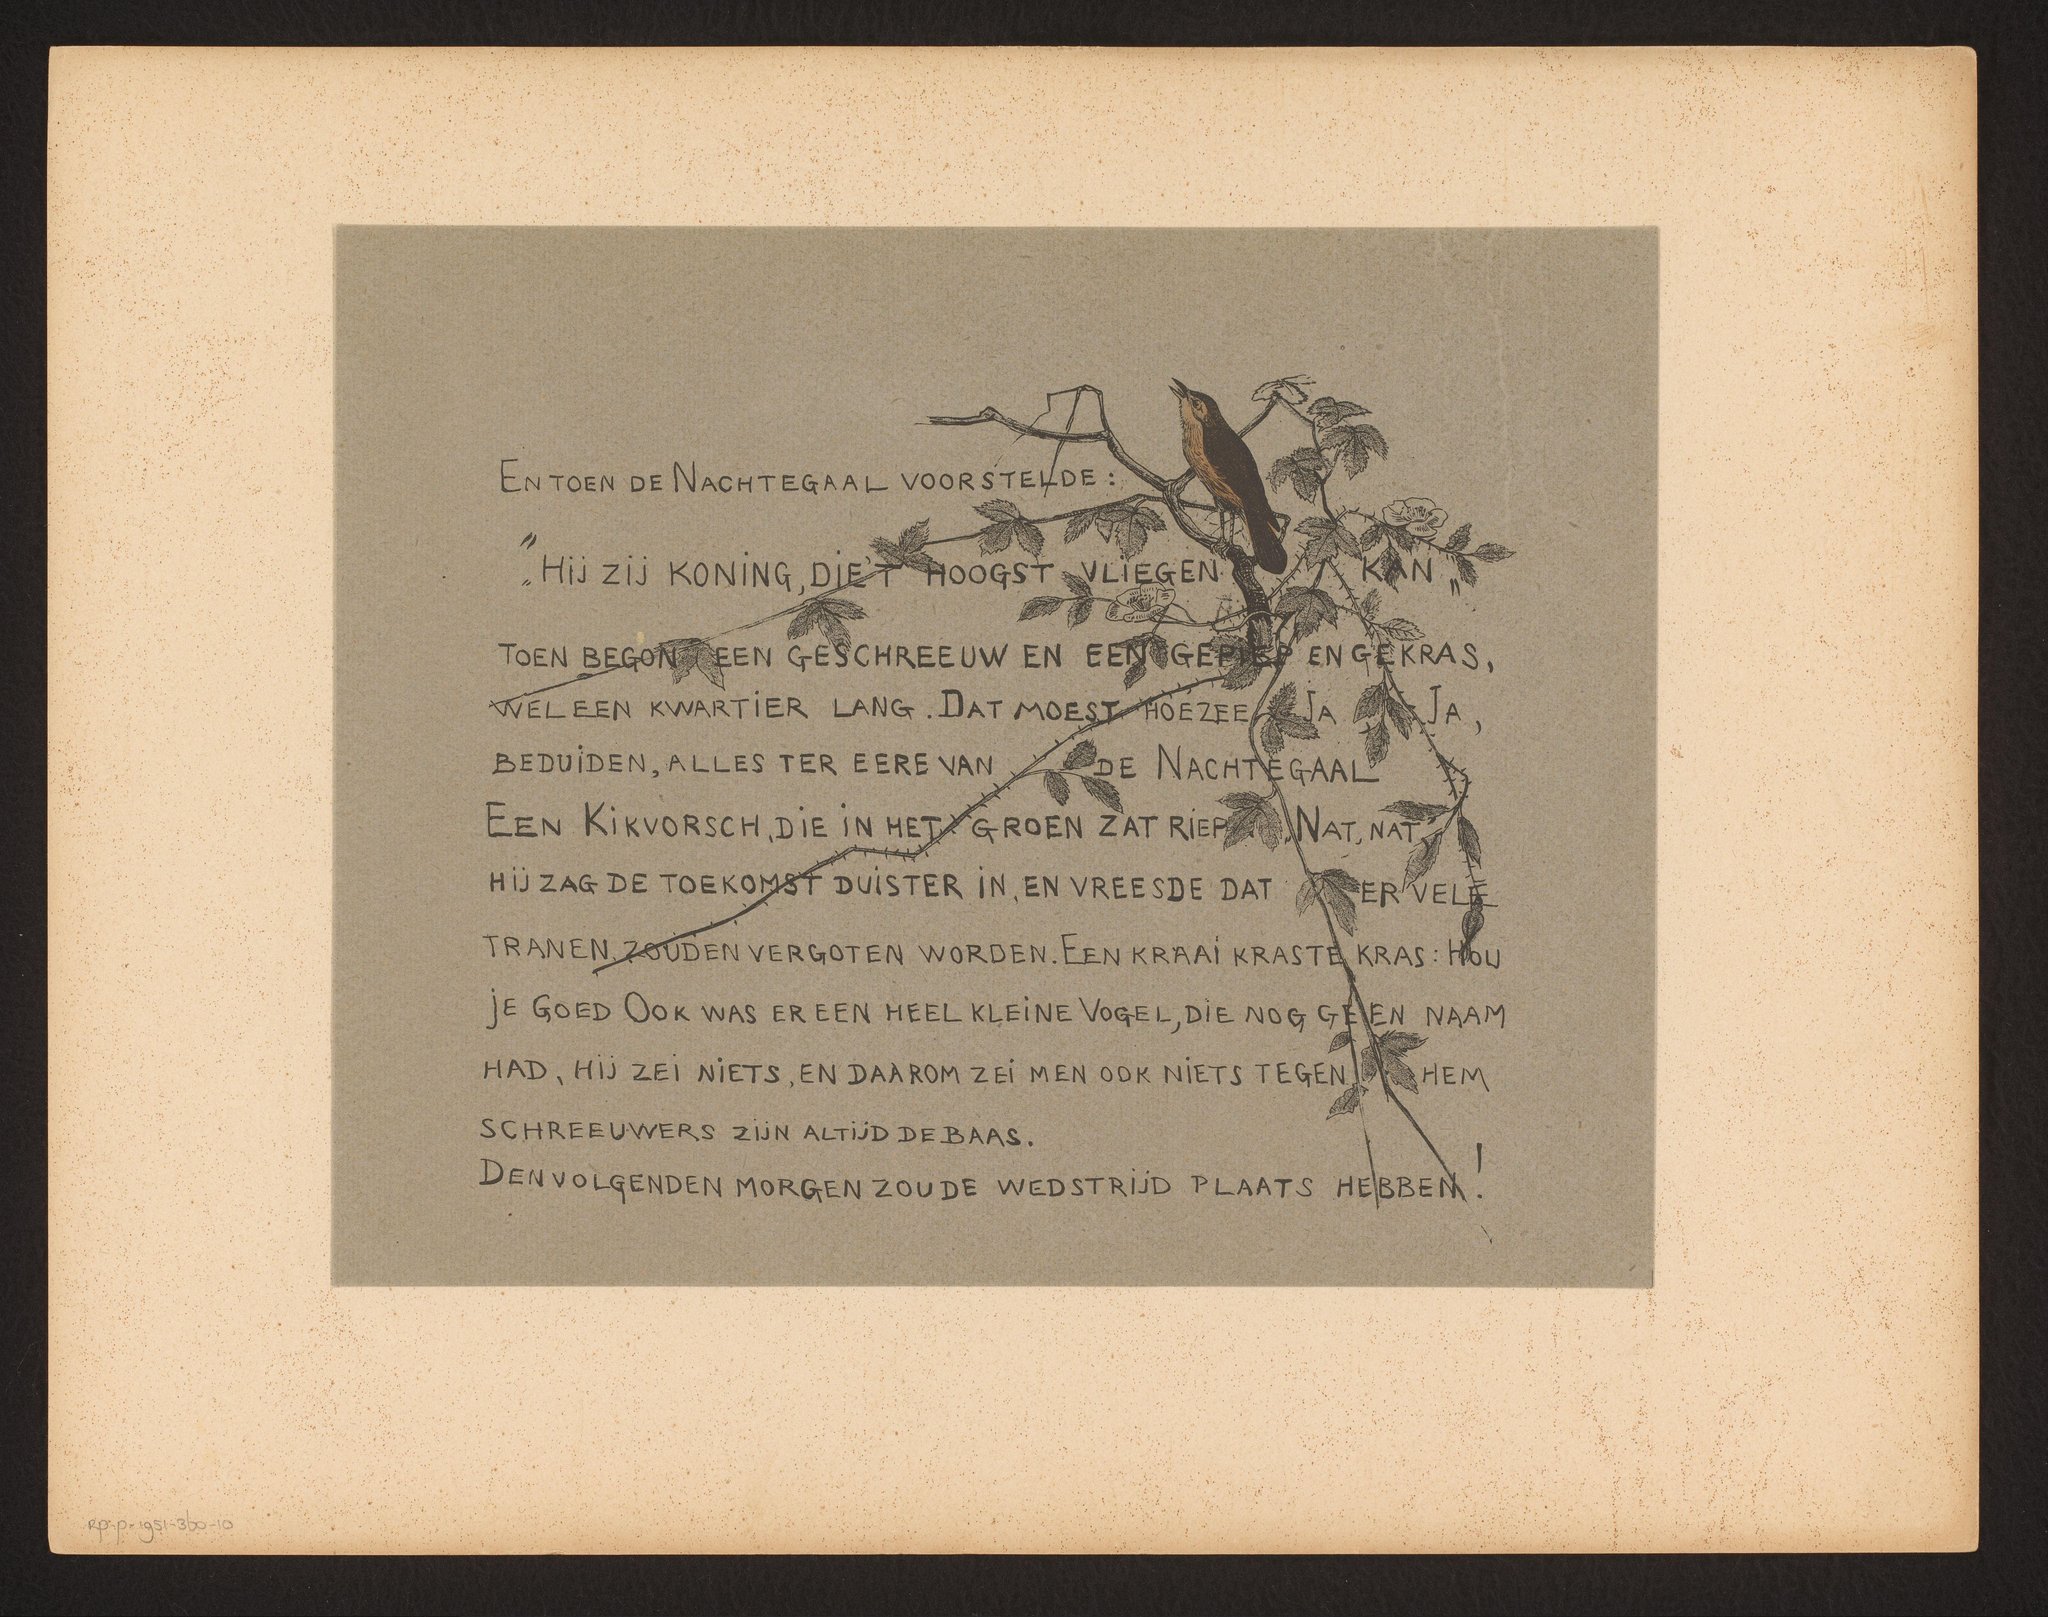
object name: print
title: Tekstblad met nachtegaal op een tak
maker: theo van hoytema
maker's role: draughtsman, painter, print maker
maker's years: 1863-1917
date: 1892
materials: paper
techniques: hand coloring, lithograph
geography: the hague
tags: song-birds: nightingale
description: Zowel tekst als afbeelding zijn gelithografeerd.